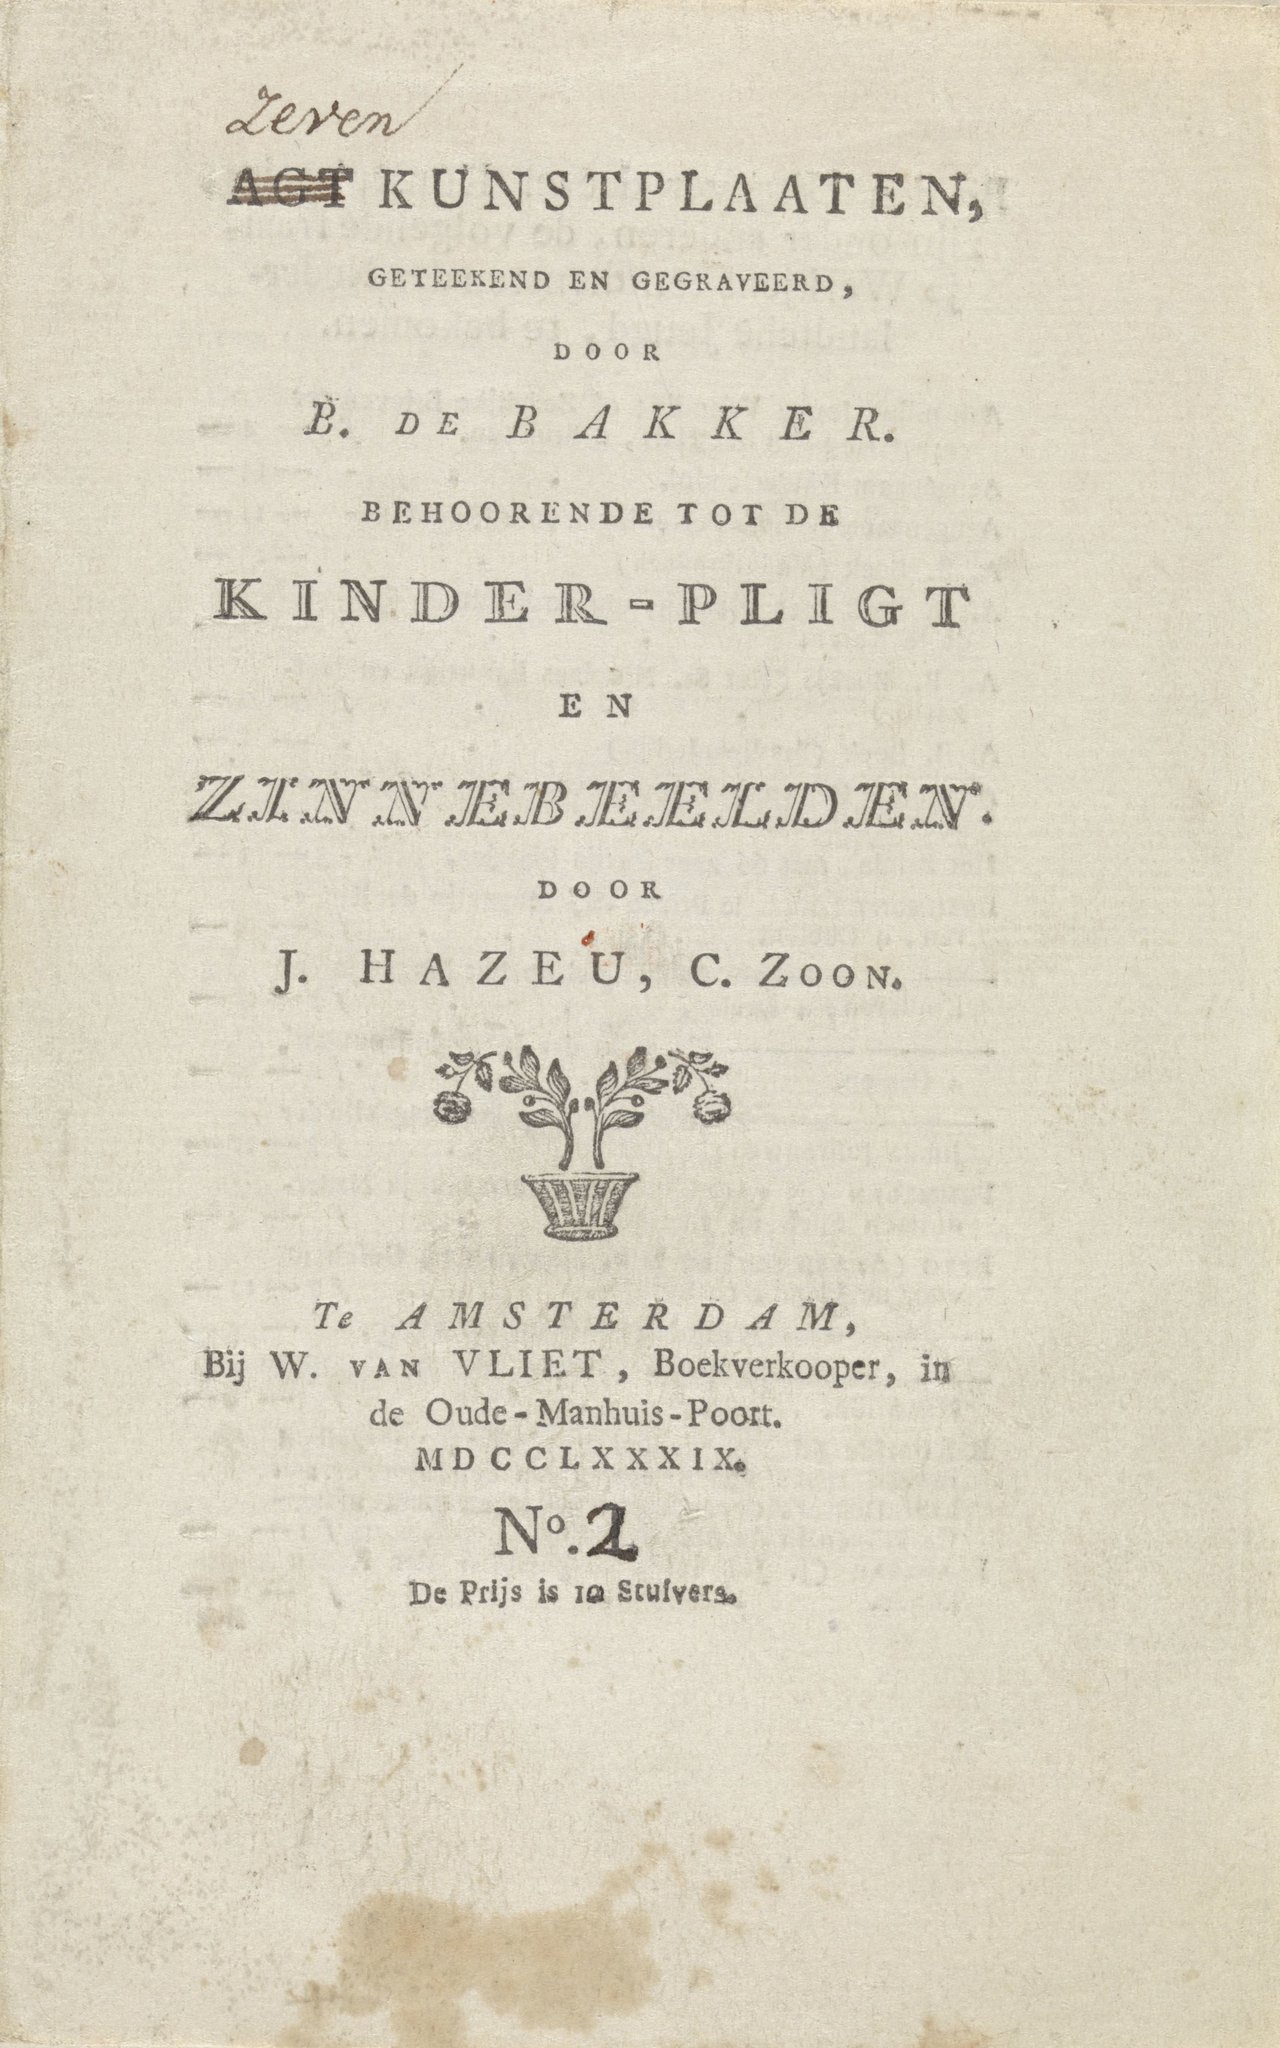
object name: print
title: Kinderpligt en zinnebeelden 2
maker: willem van vliet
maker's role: publisher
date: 1789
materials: paper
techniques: letterpress printing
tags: haarlem, johannes hazeu cornelisz.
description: Prent uit: Hazeu, Johannes Cornelisz., Agt kunstplaaten behoorende tot de Kinderpligt en zinnebeelden, Willem van Vliet (uitgever), Amsterdam 1789. De serie bevat, in tegenstelling tot aantal vermeld op de titelpagina, zeven prenten.